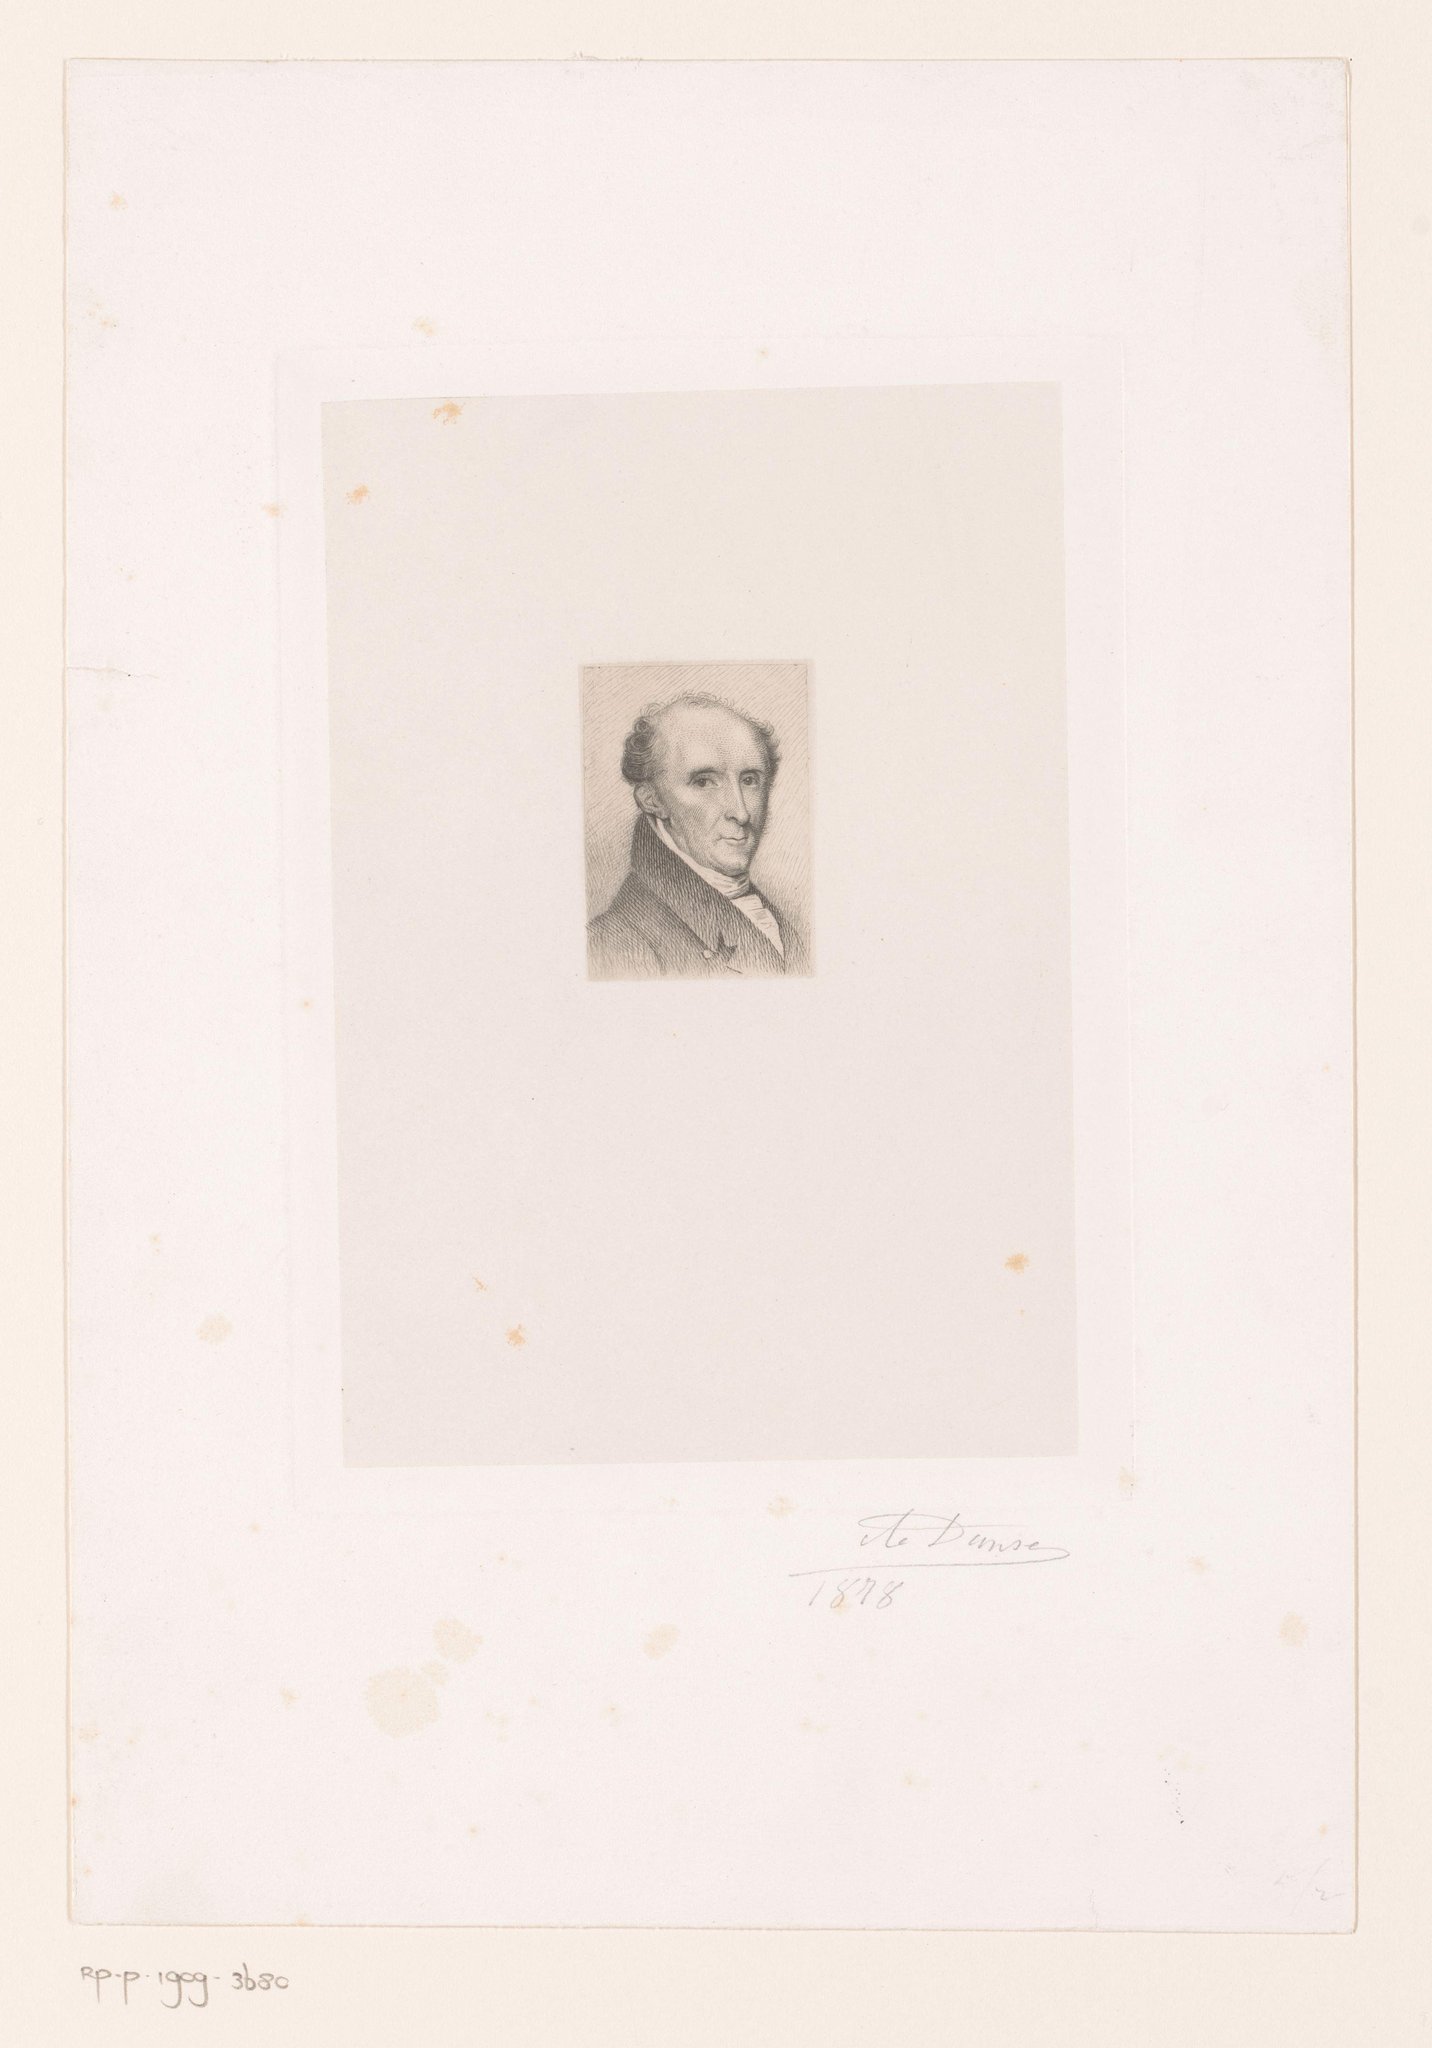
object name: print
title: Portret van een onbekende man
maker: auguste danse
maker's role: print maker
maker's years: 1829-1929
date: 1878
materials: paper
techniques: etching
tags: adult man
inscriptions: collector's mark: Lugt 2228